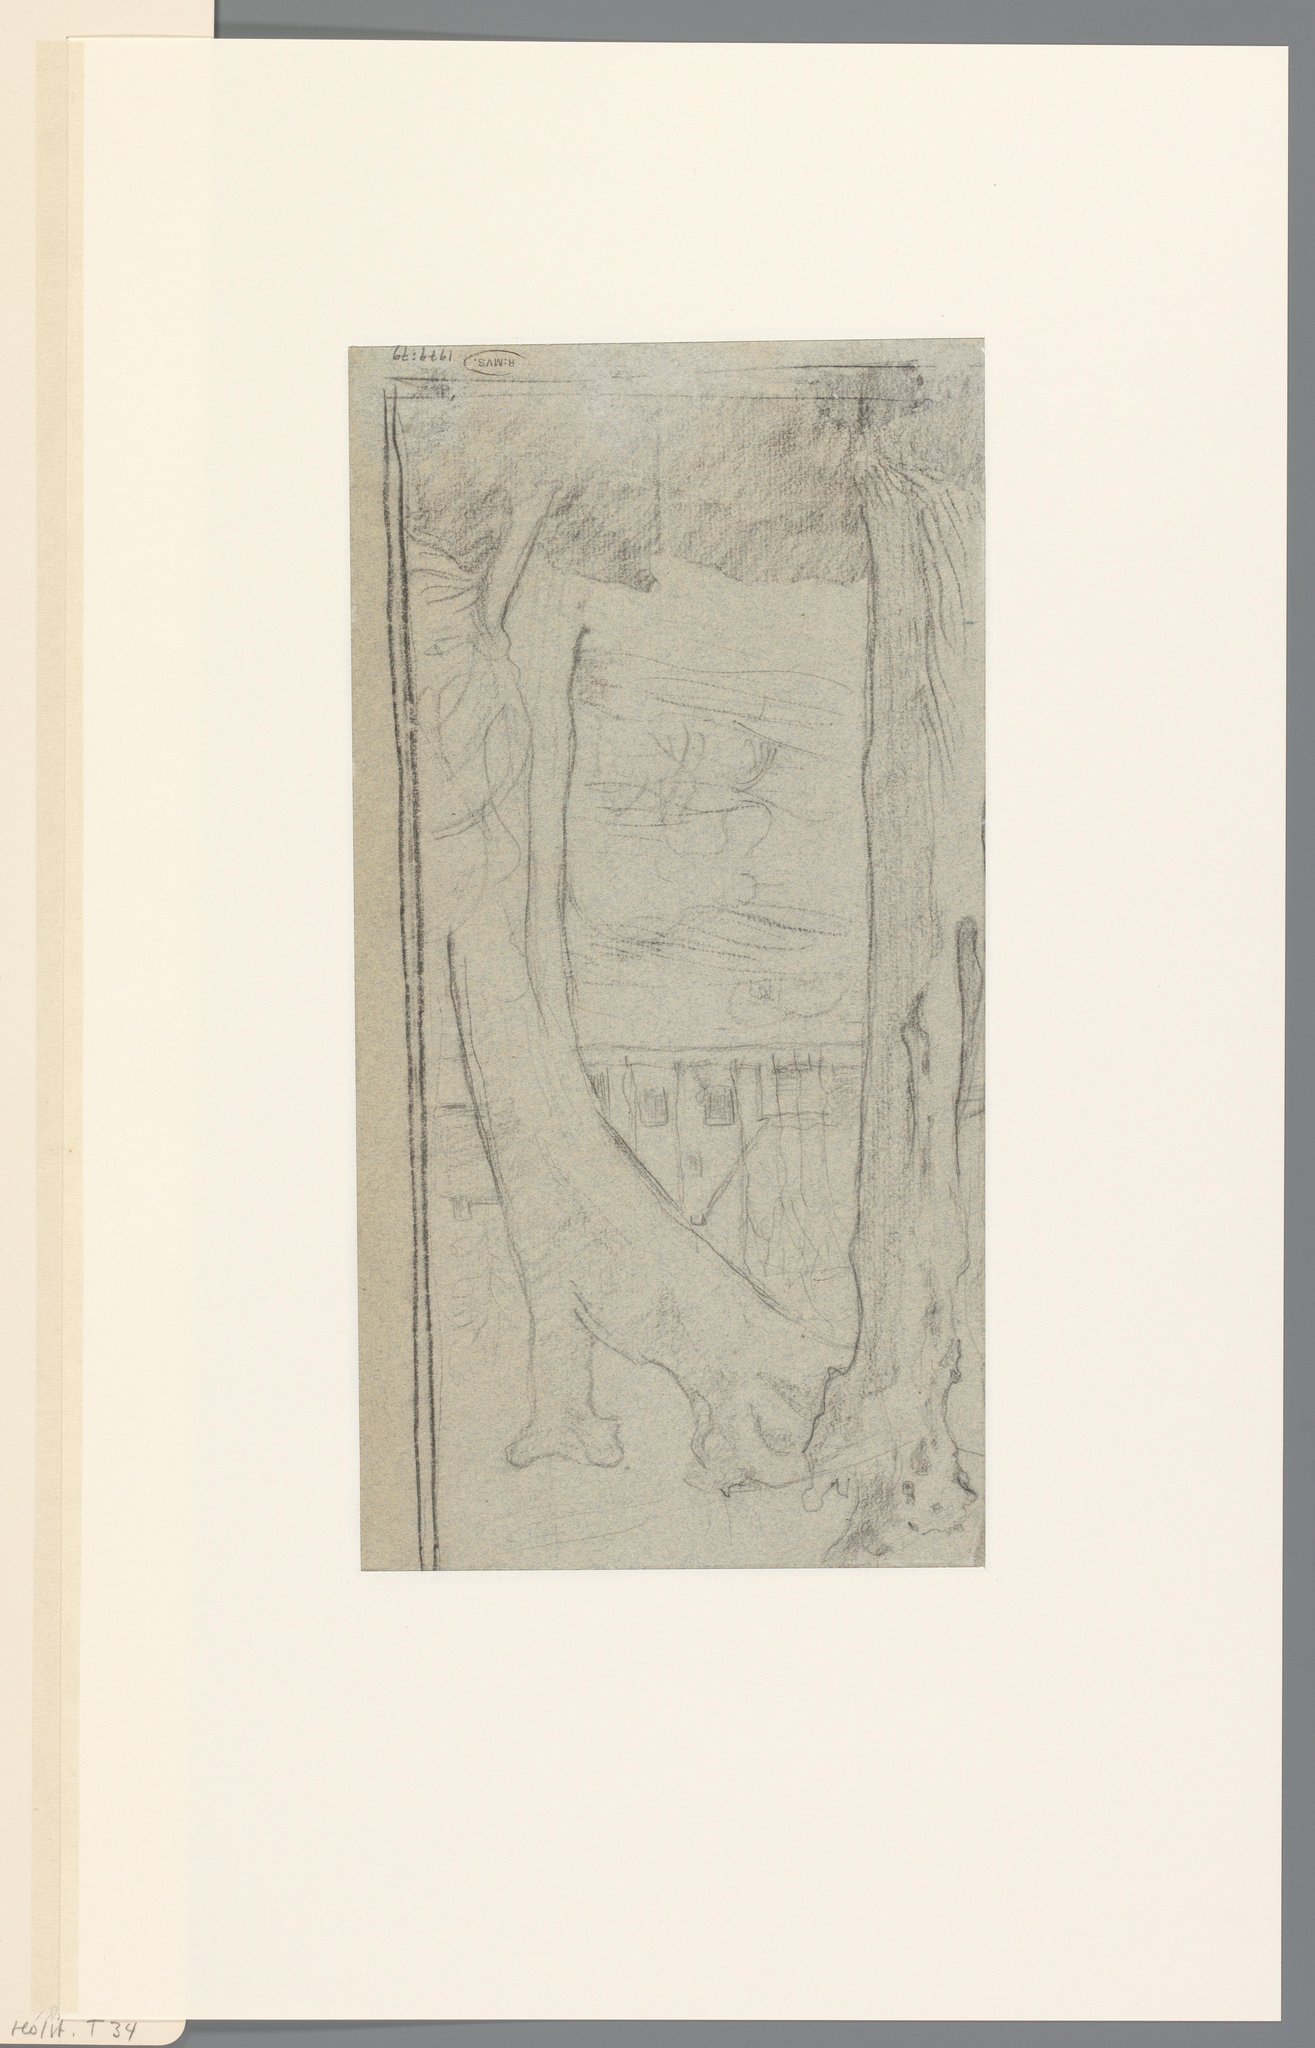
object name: drawing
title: Twee knotwilgen en boerderijen op de achtergrond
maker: richard nicolaüs roland holst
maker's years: 1868-1938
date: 1897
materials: chalk, paper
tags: trees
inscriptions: date: ‘97’